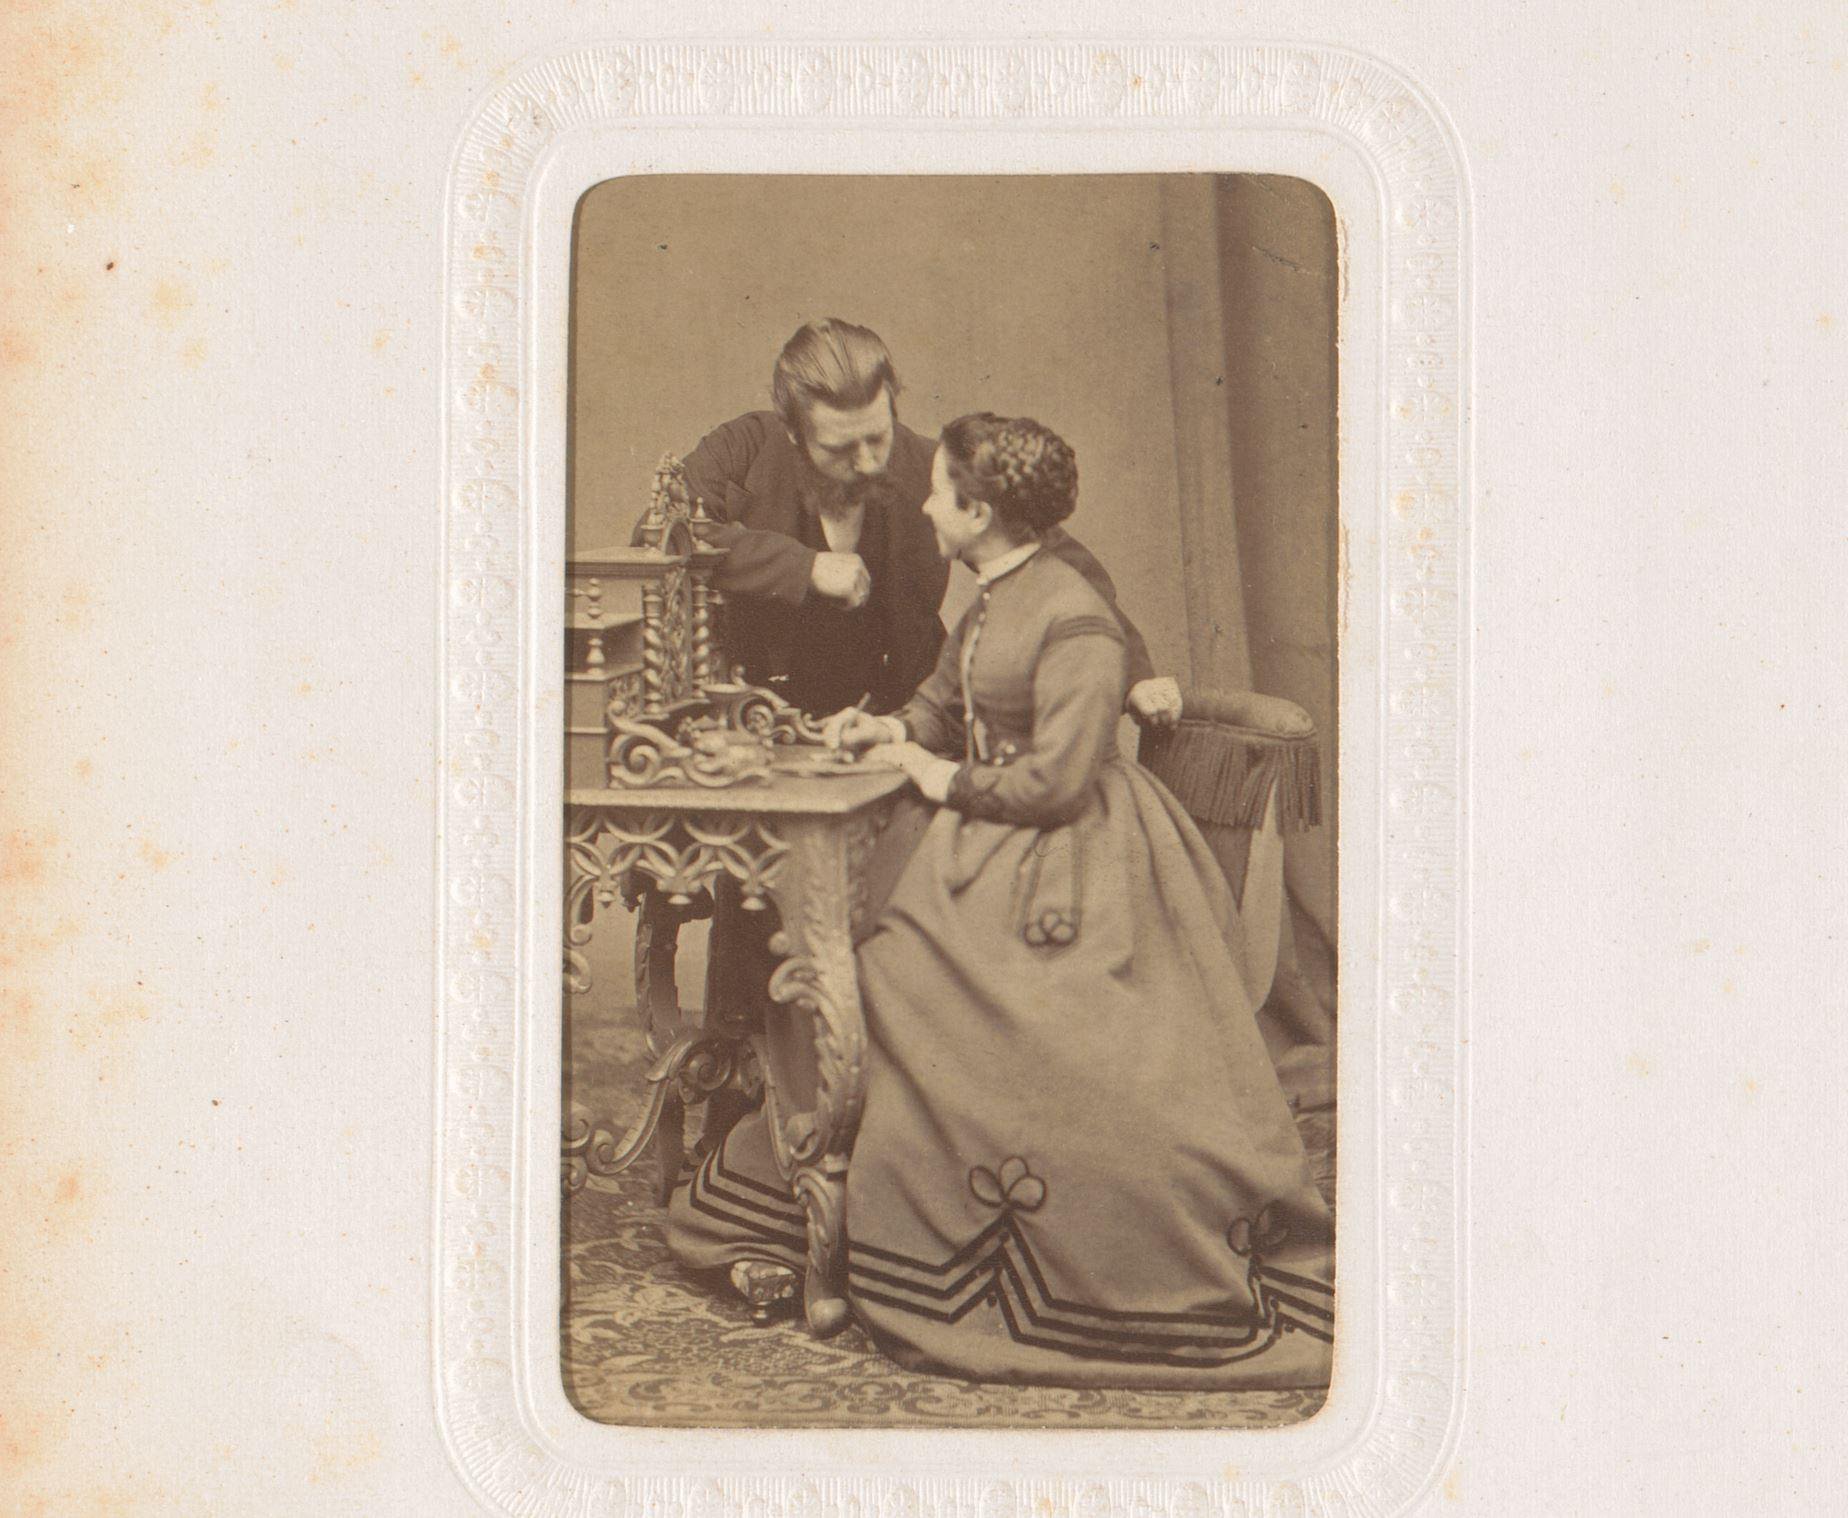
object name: album leaf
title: Portret van een man en een vrouw, de vrouw zittend aan een tafel met pen in de hand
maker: Anonymous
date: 1860-1900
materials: cardboard, photographic support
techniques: albumen print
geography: netherlands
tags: sitting figure - aa - female human figure, historical persons - bb - woman, historical persons, writing and letters